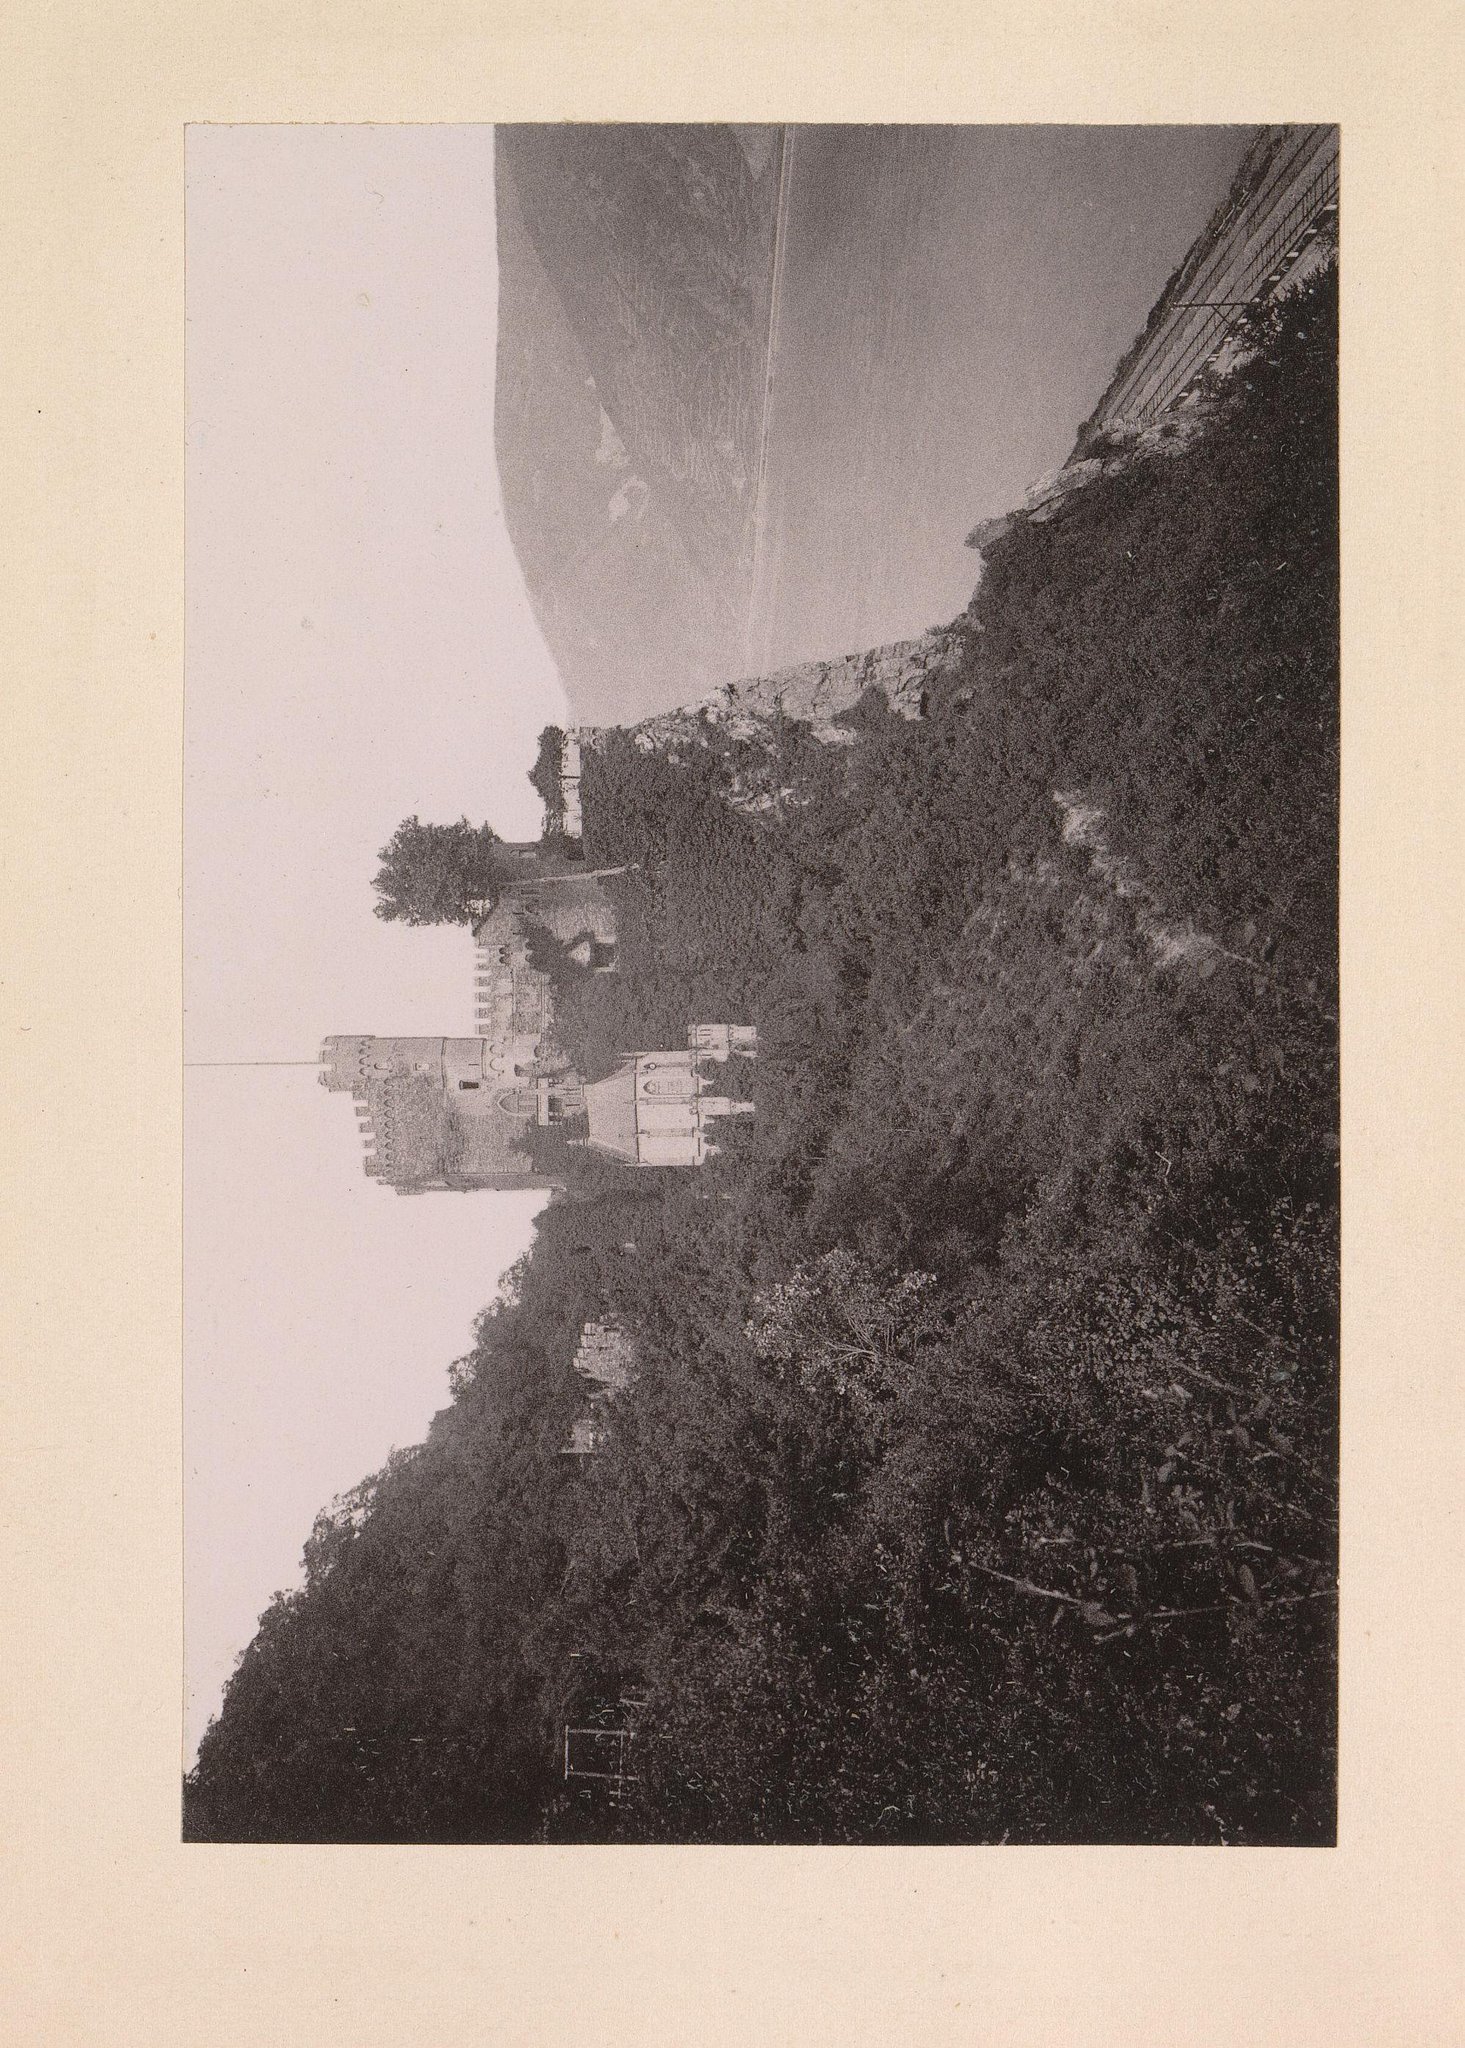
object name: page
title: Gezicht op Burg Rheinstein bij Trechtingshausen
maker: Anonymous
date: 1881-1891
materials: paper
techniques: photograph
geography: trechtingshausen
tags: castle, river